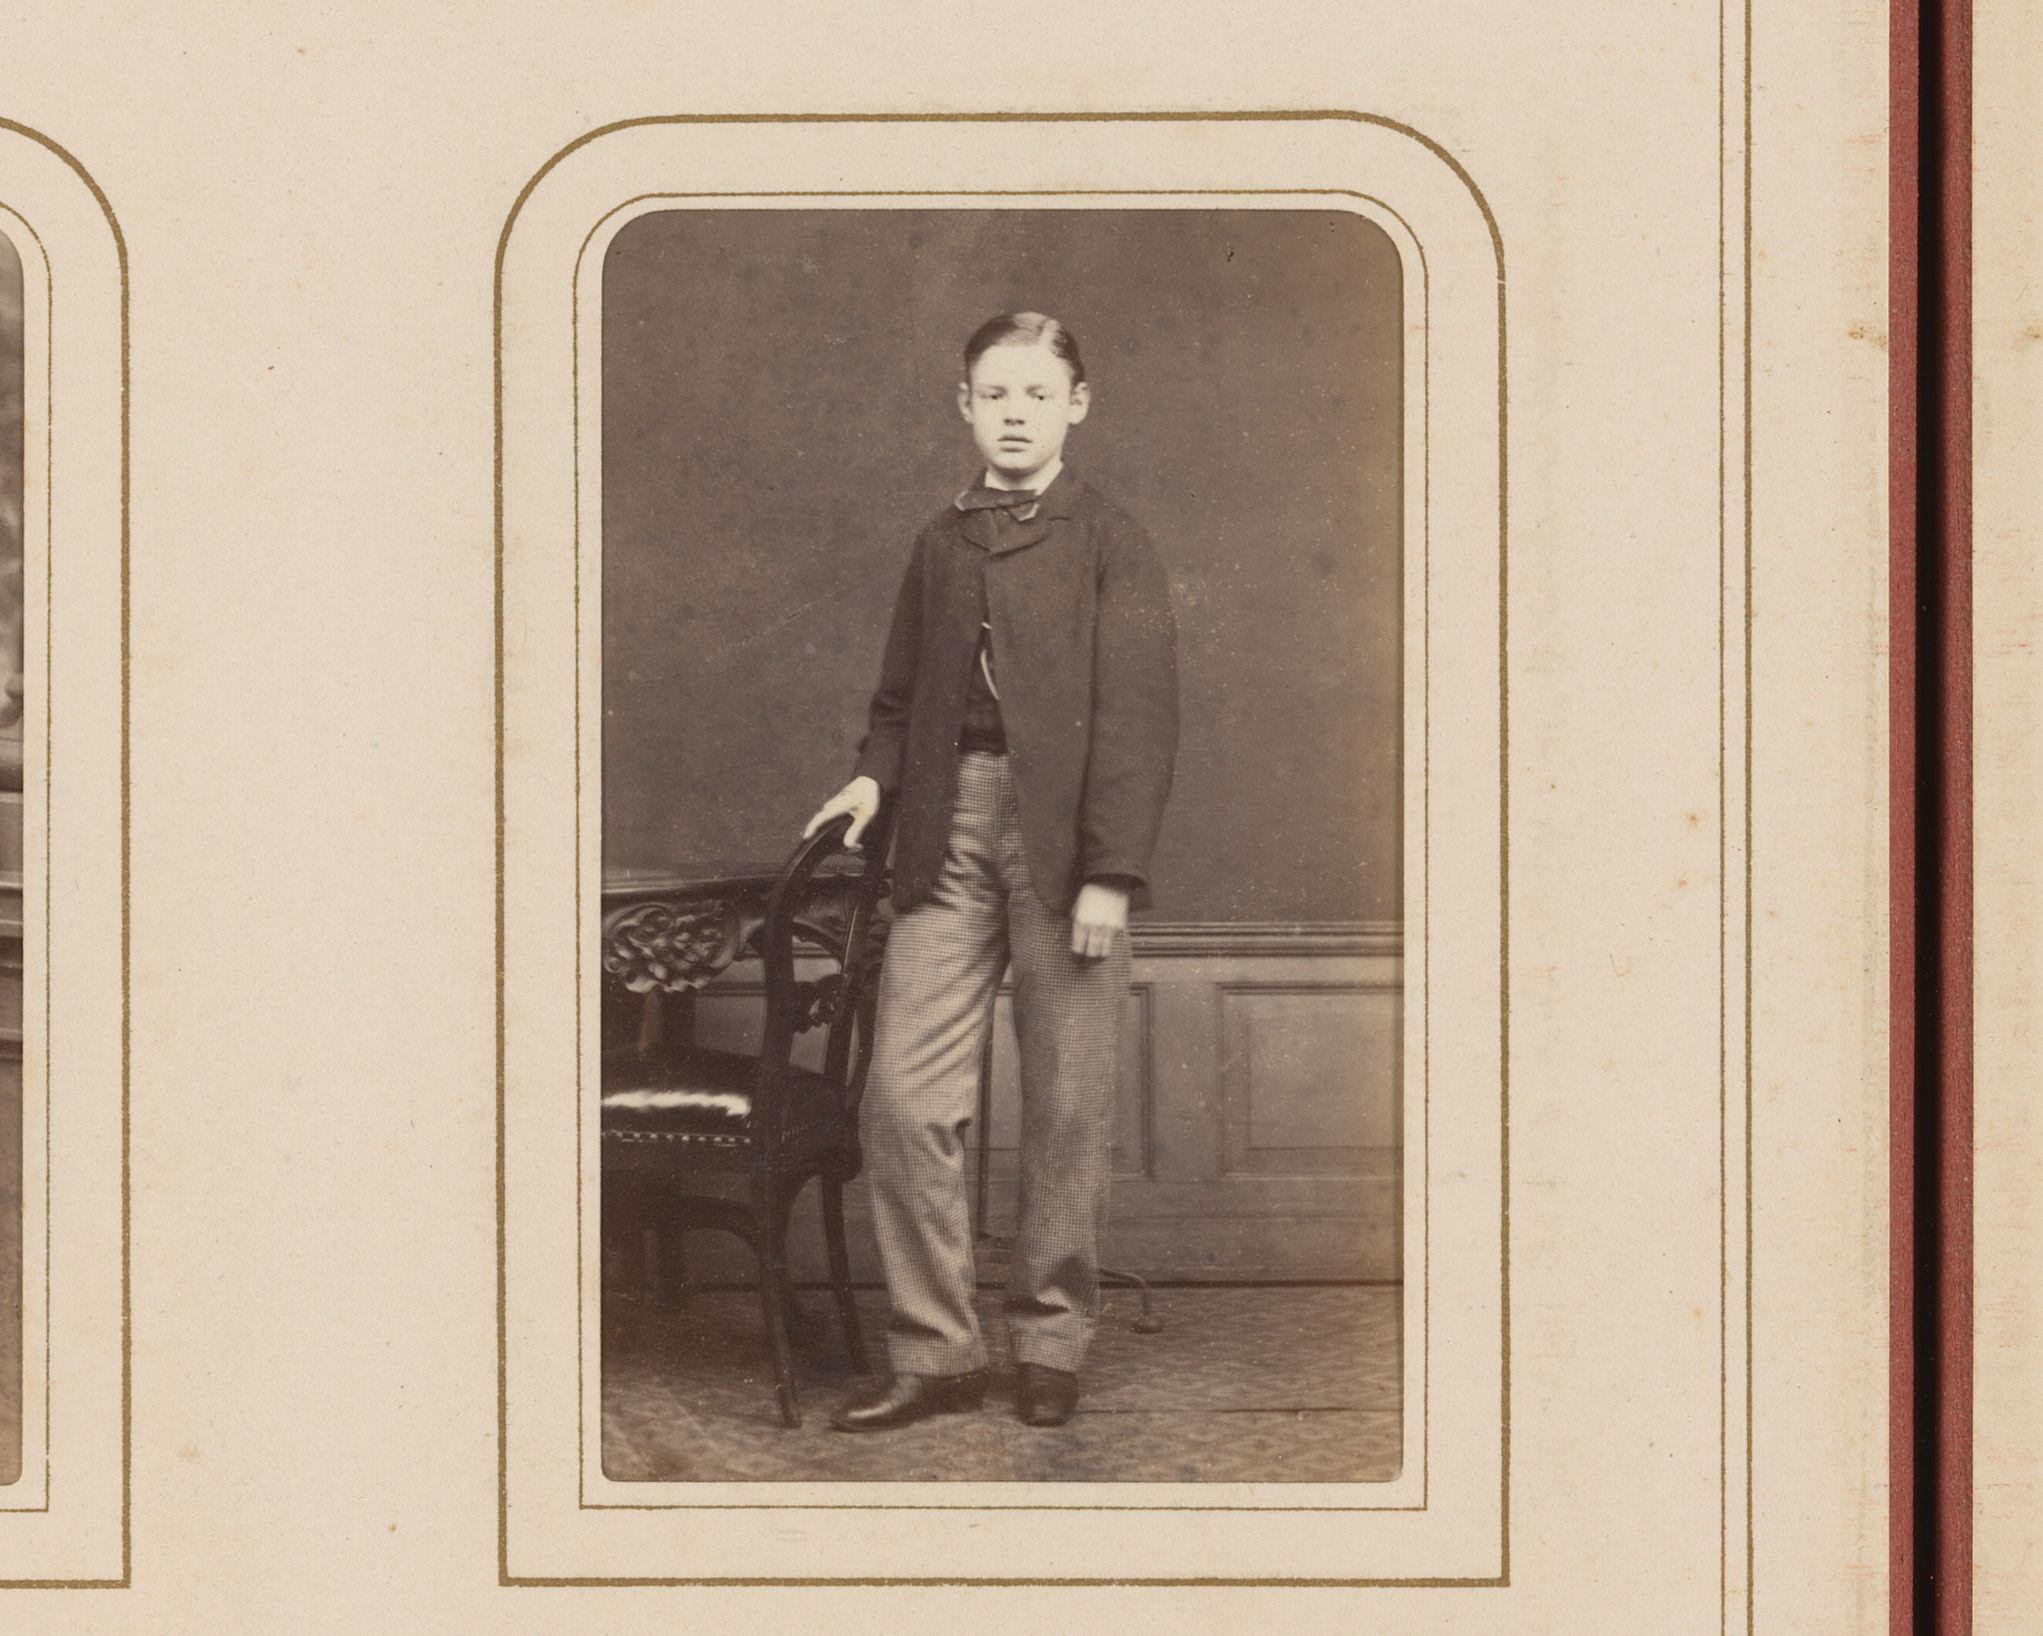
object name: photograph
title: Portret van een jongen, staand bij een stoel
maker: gerrit hoogwinkel jr.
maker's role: fotograaf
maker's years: 1837-1890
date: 1859-1890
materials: cardboard, photographic support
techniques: albumen print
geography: rotterdam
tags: boy (child between toddler and youth), historical persons, chair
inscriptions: inscription: ‘G. Hoogwinkel jr./ PHOTOGRAPHE/ ROTTERDAM. 56, Hoogstraat.’